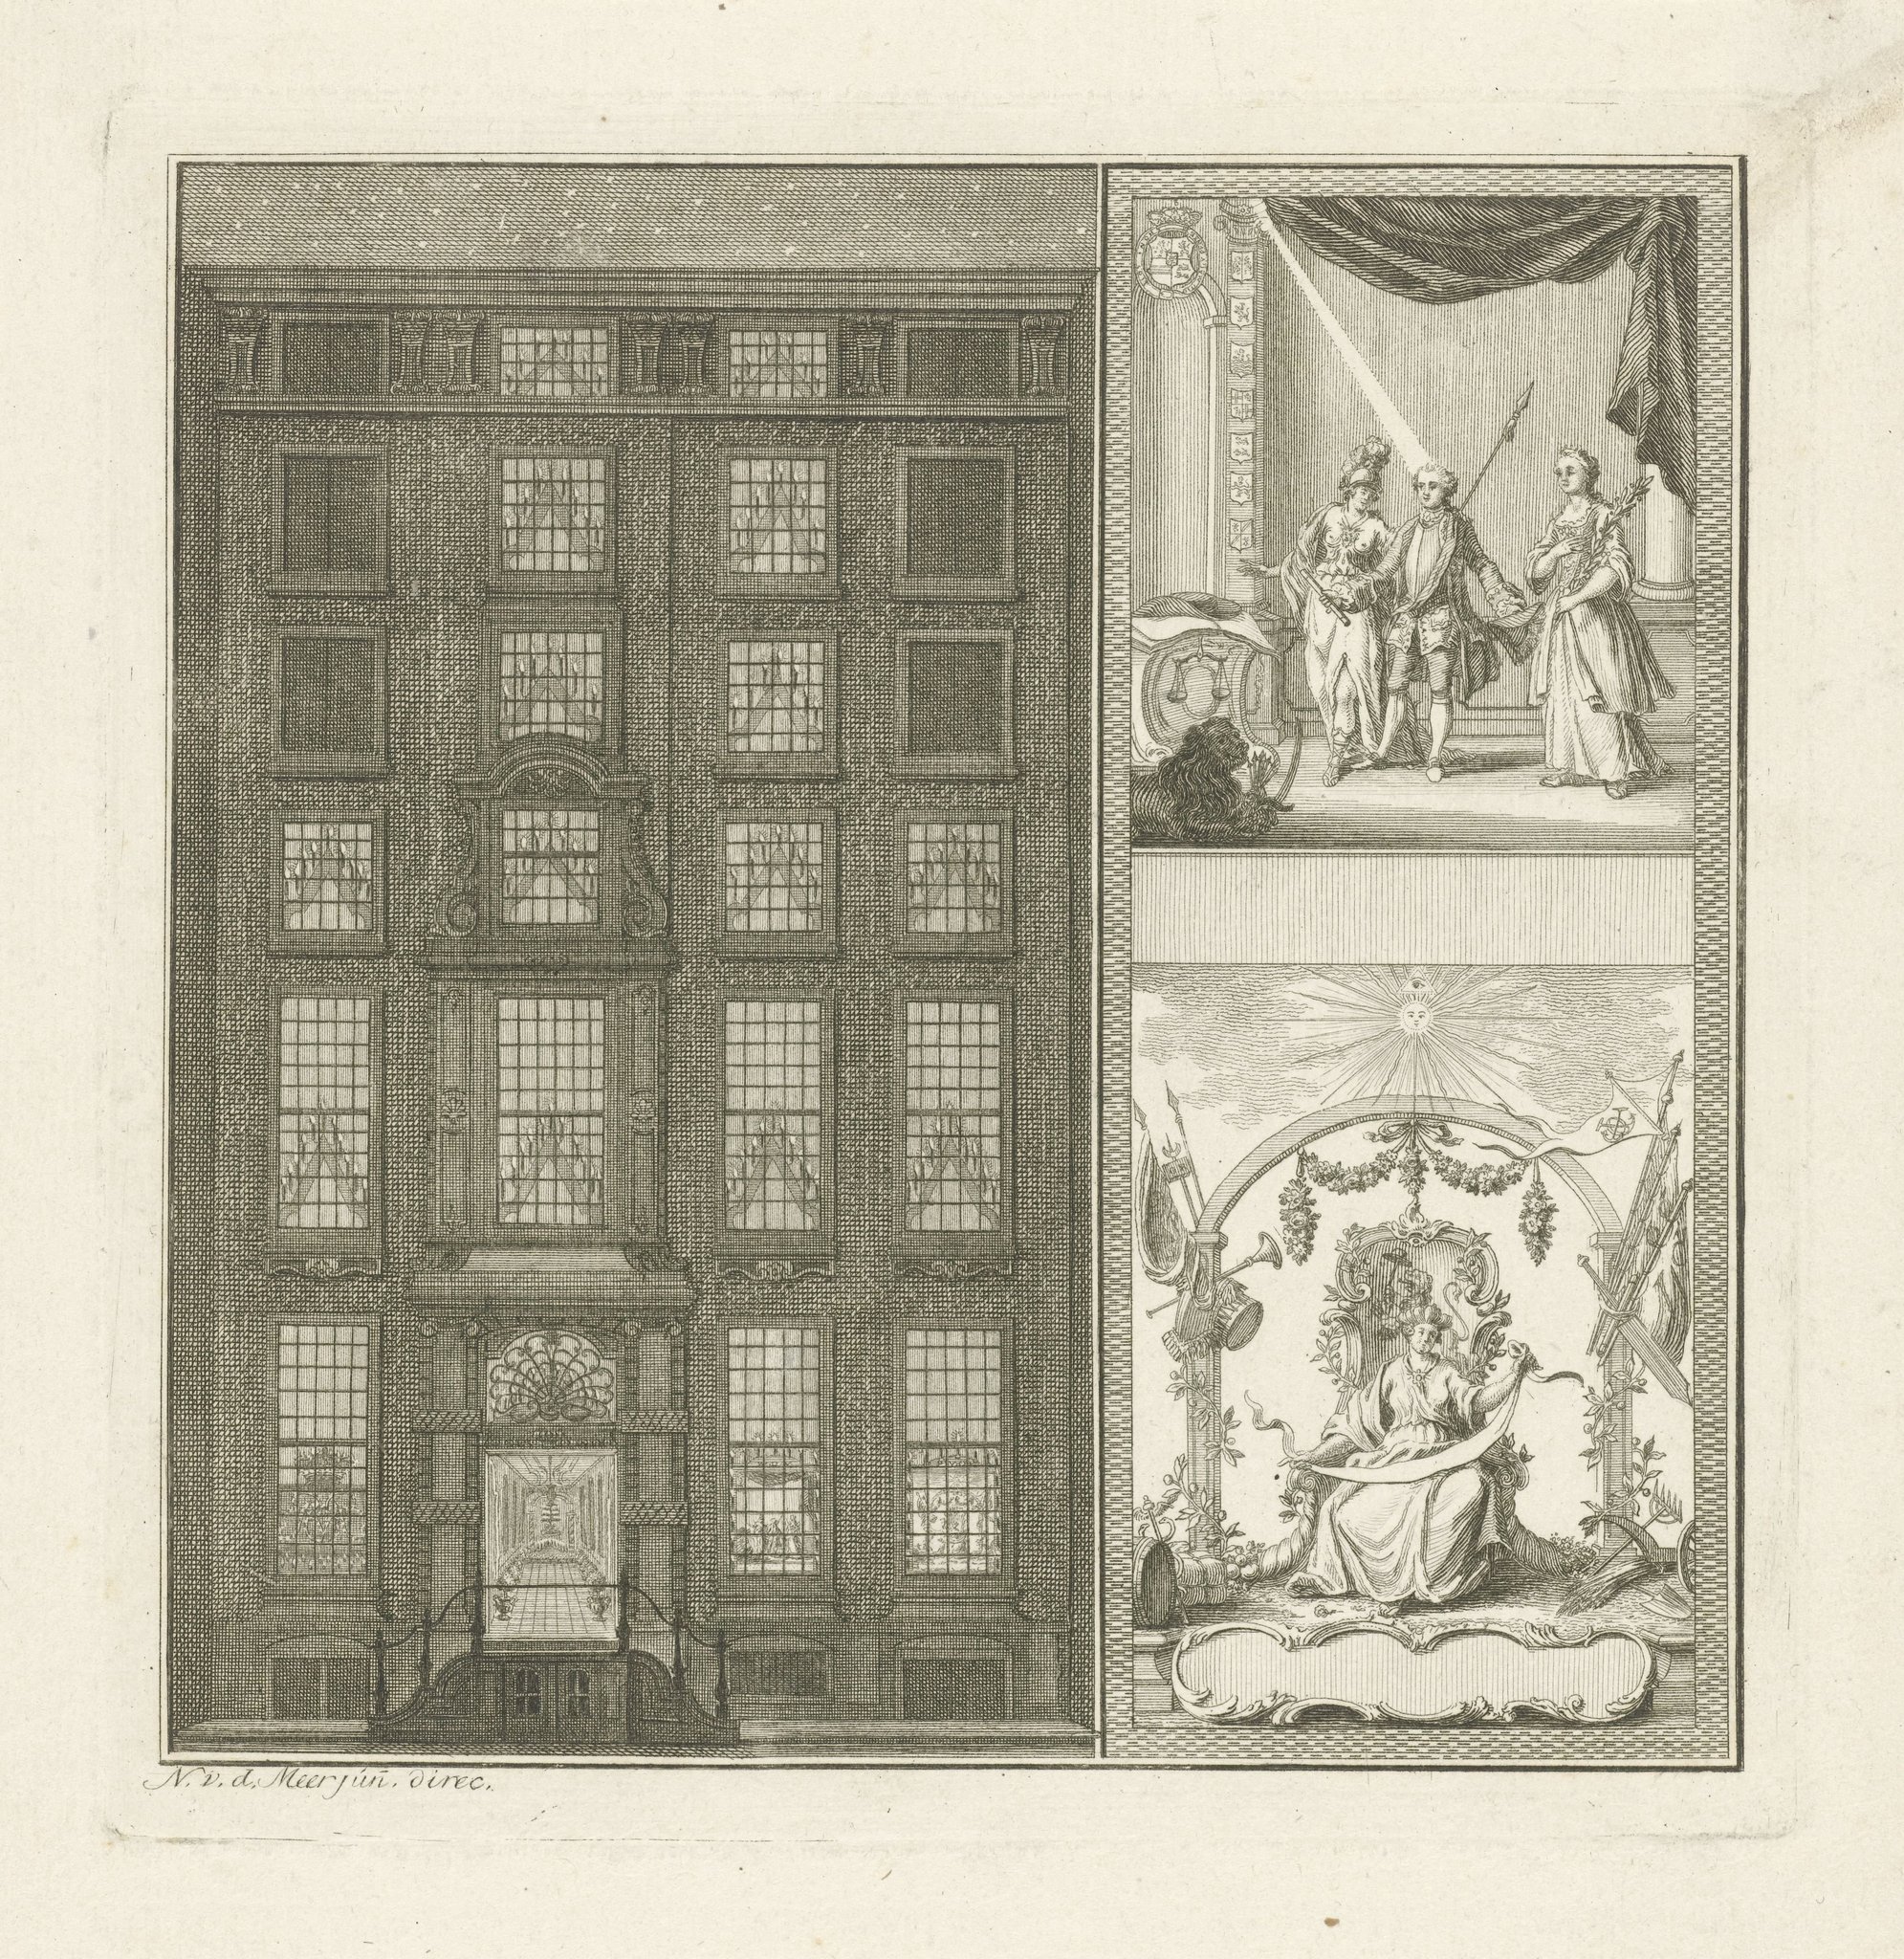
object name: print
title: Illuminatië van het huis van de heer J.A. Scholten van Aschat te Amsterdam, 1766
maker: noach van der meer (ii)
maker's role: draughtsman, print maker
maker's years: 1741-1822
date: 1776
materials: paper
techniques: etching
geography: amsterdam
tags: william v (prince of orange), faith, 'fides'; 'fede', 'fede catholica', 'fede christiana', 'fede christiana catholica' (ripa) ~ one of the three theological virtues, truth; 'verità' (ripa), public festivities, the all-seeing eye, triangle with eye ~ symbol of god the father, freedom, liberty; 'libertà' (ripa)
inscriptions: collector's mark: Lugt 2228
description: Verlichting van het woonhuis van de heer Scholten van Aschat in Amsterdam ter ere van de aantreding van Willem V als stadhouder in 1766. Rechtsboven stadhouder Willem V staande tussen Godsdienst en Vrijheid. De Hollandse leeuw ligt op de grond. Rechtsonder zit de personificatie van Gerechtigheid en Waarheid op de troon onder de zon van gerechtigheid en het alziend oog van God. De troon is gedecoreerd met de Hollandse leeuw met vrijheidslans.